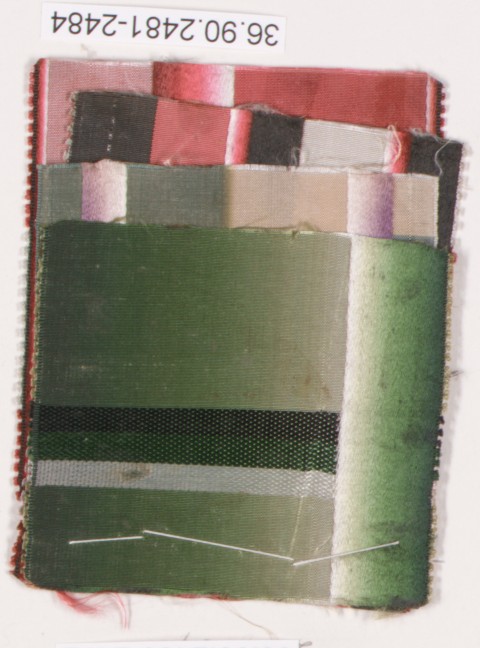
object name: ribbon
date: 1801-1900